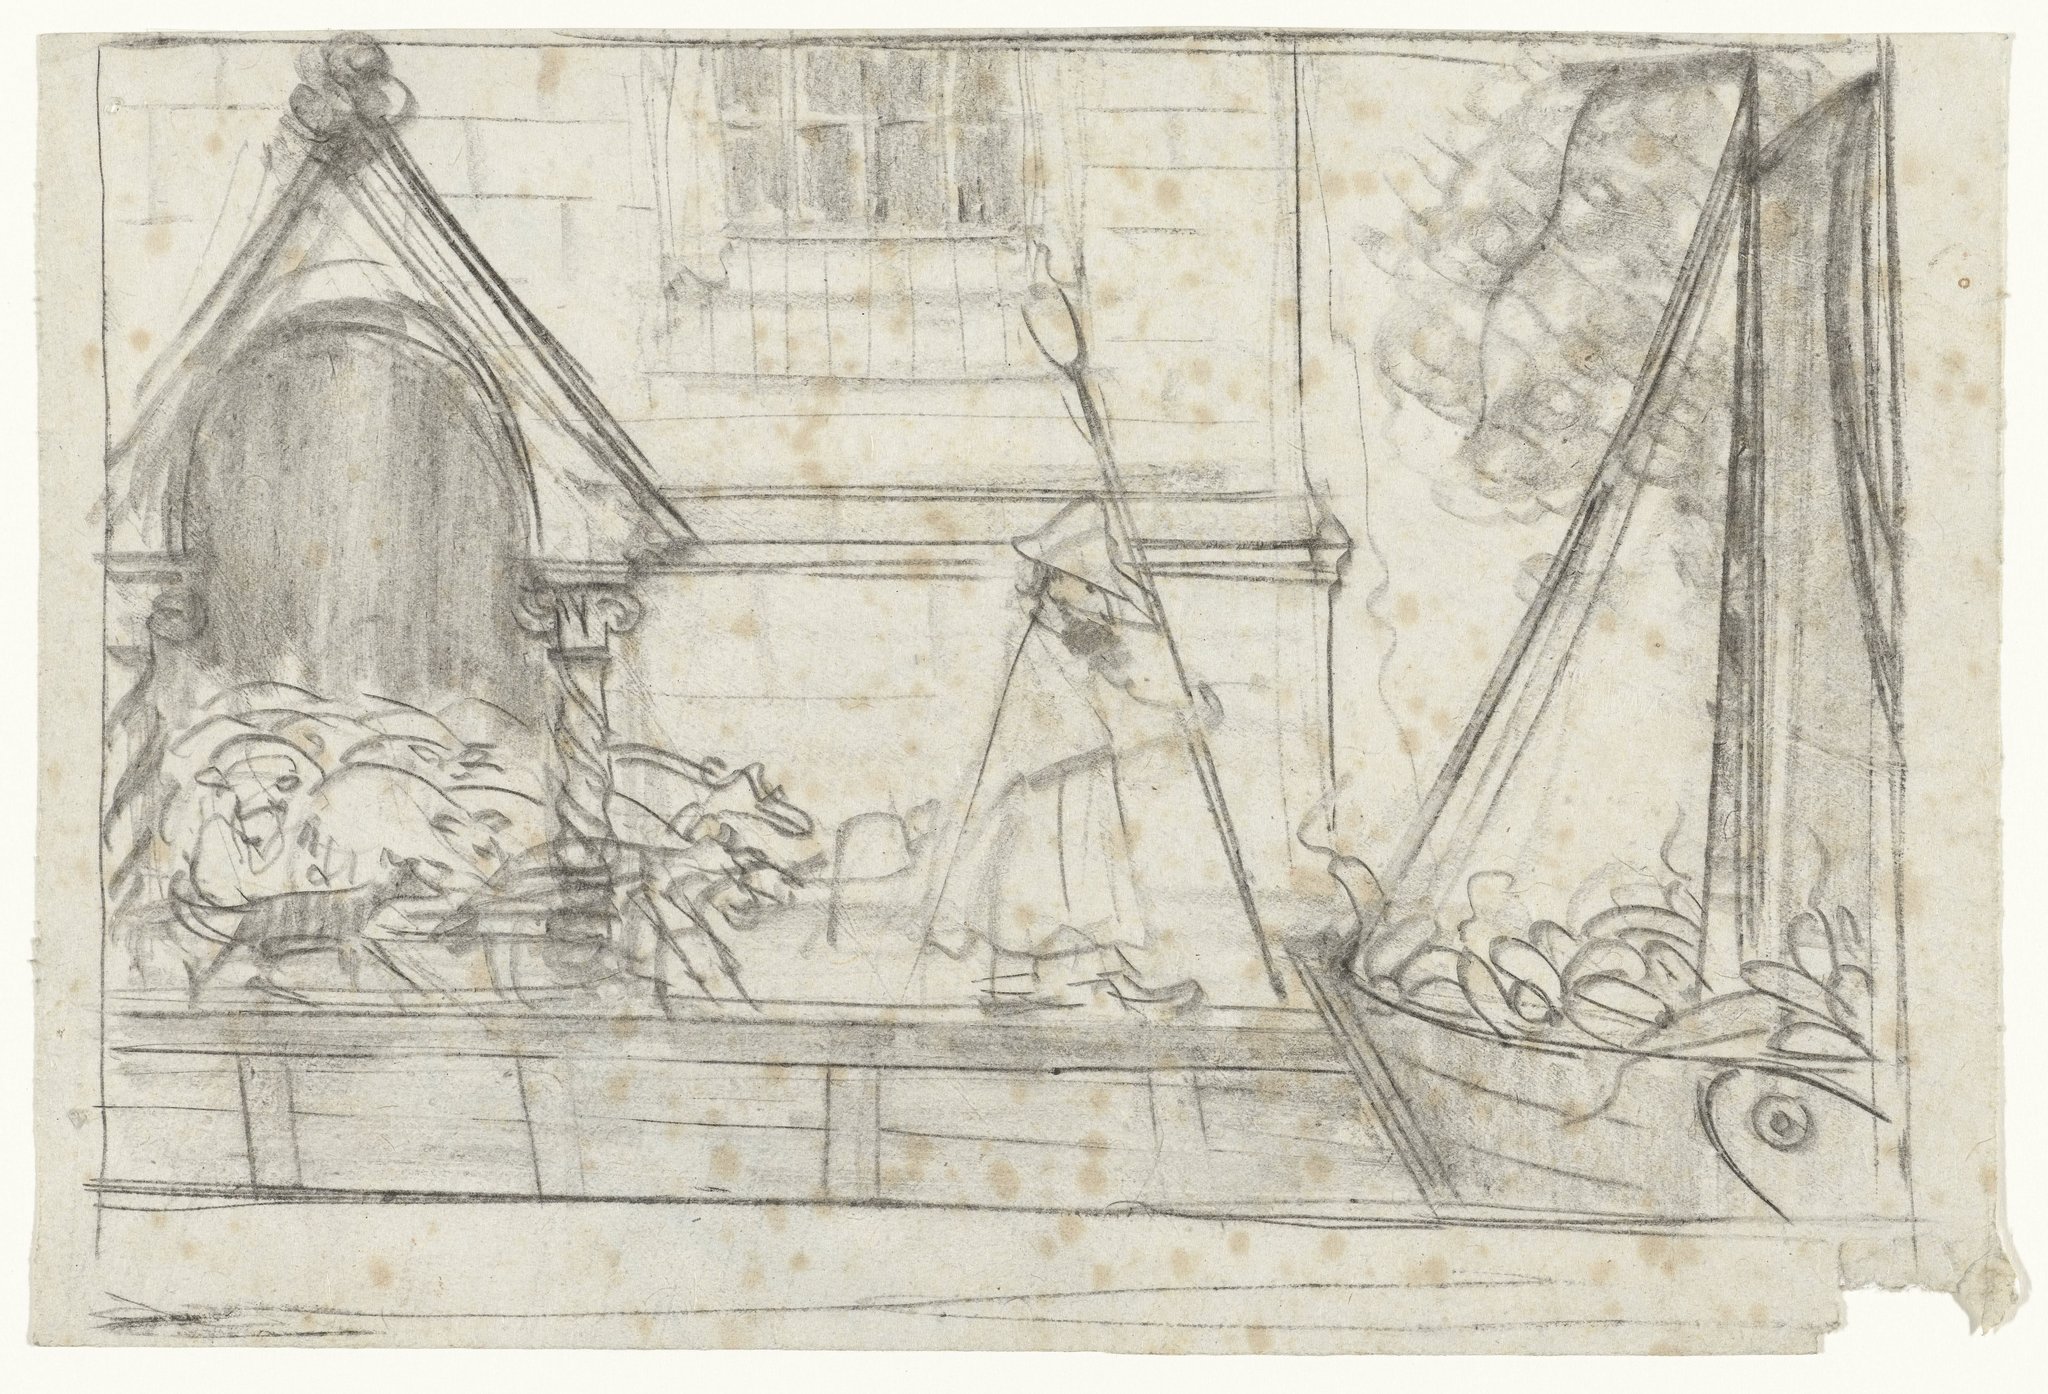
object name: design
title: Ontwerp voor reclame van Nutrix beschuit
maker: gerrit willem dijsselhof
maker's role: designer, draughtsman, print maker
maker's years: 1866-1924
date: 1876-1924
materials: chalk, paper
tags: advertising, (other) historical names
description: Ontwerp voor reclame van Nutrix beschuit `De holle bolle wagen': een kerk vol schapen, een schuit vol rapen.